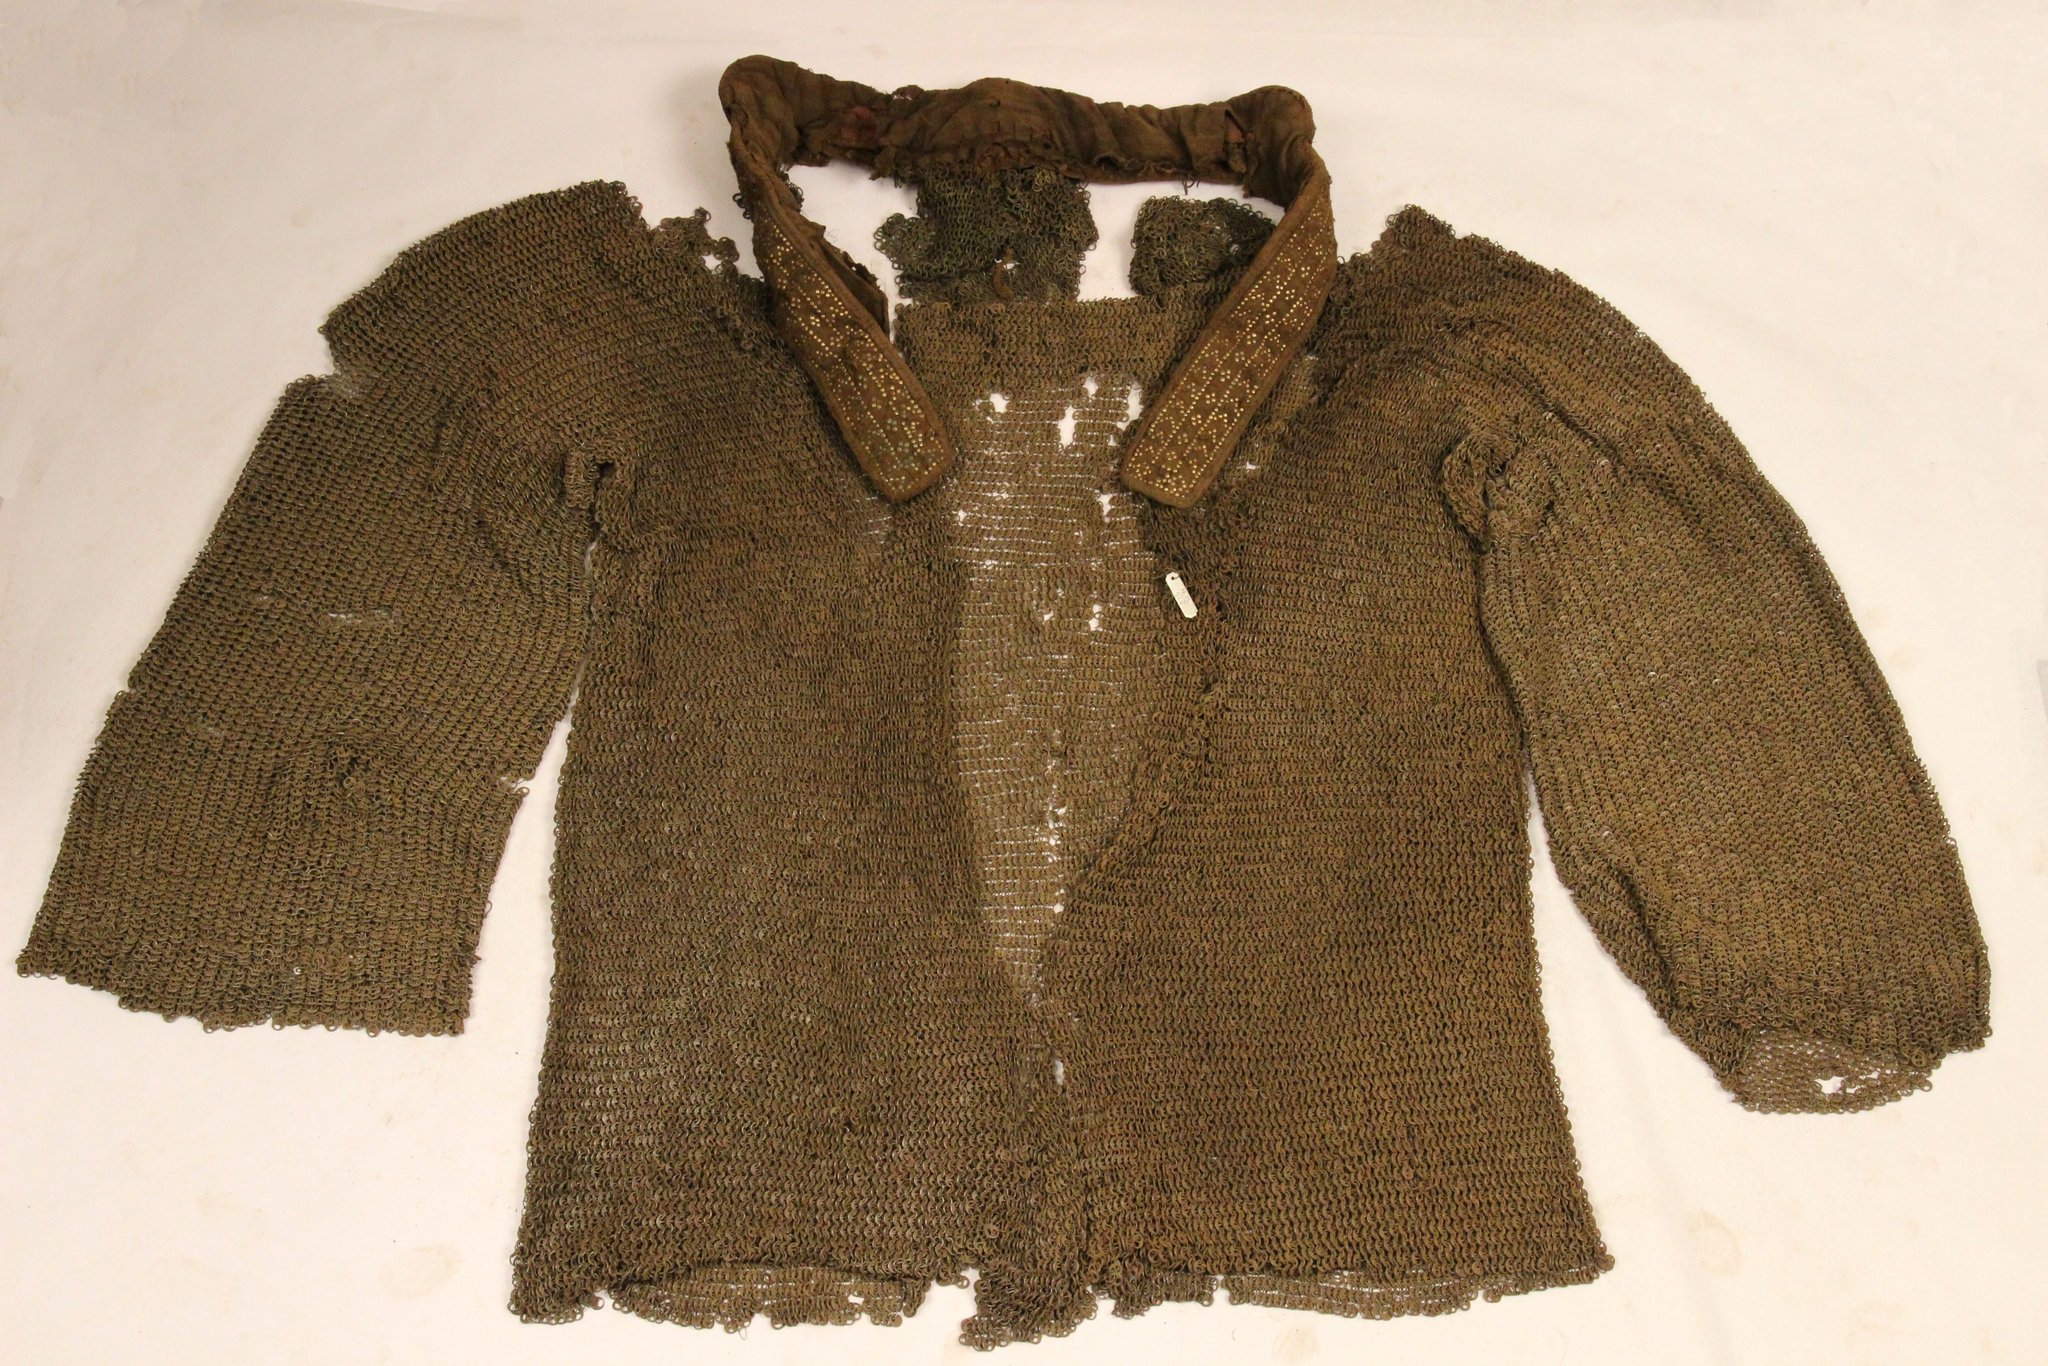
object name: shirt of mail zireh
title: Shirt of Mail (Zireh)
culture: indian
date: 1701-1900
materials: copper alloy, steel, textile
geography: india